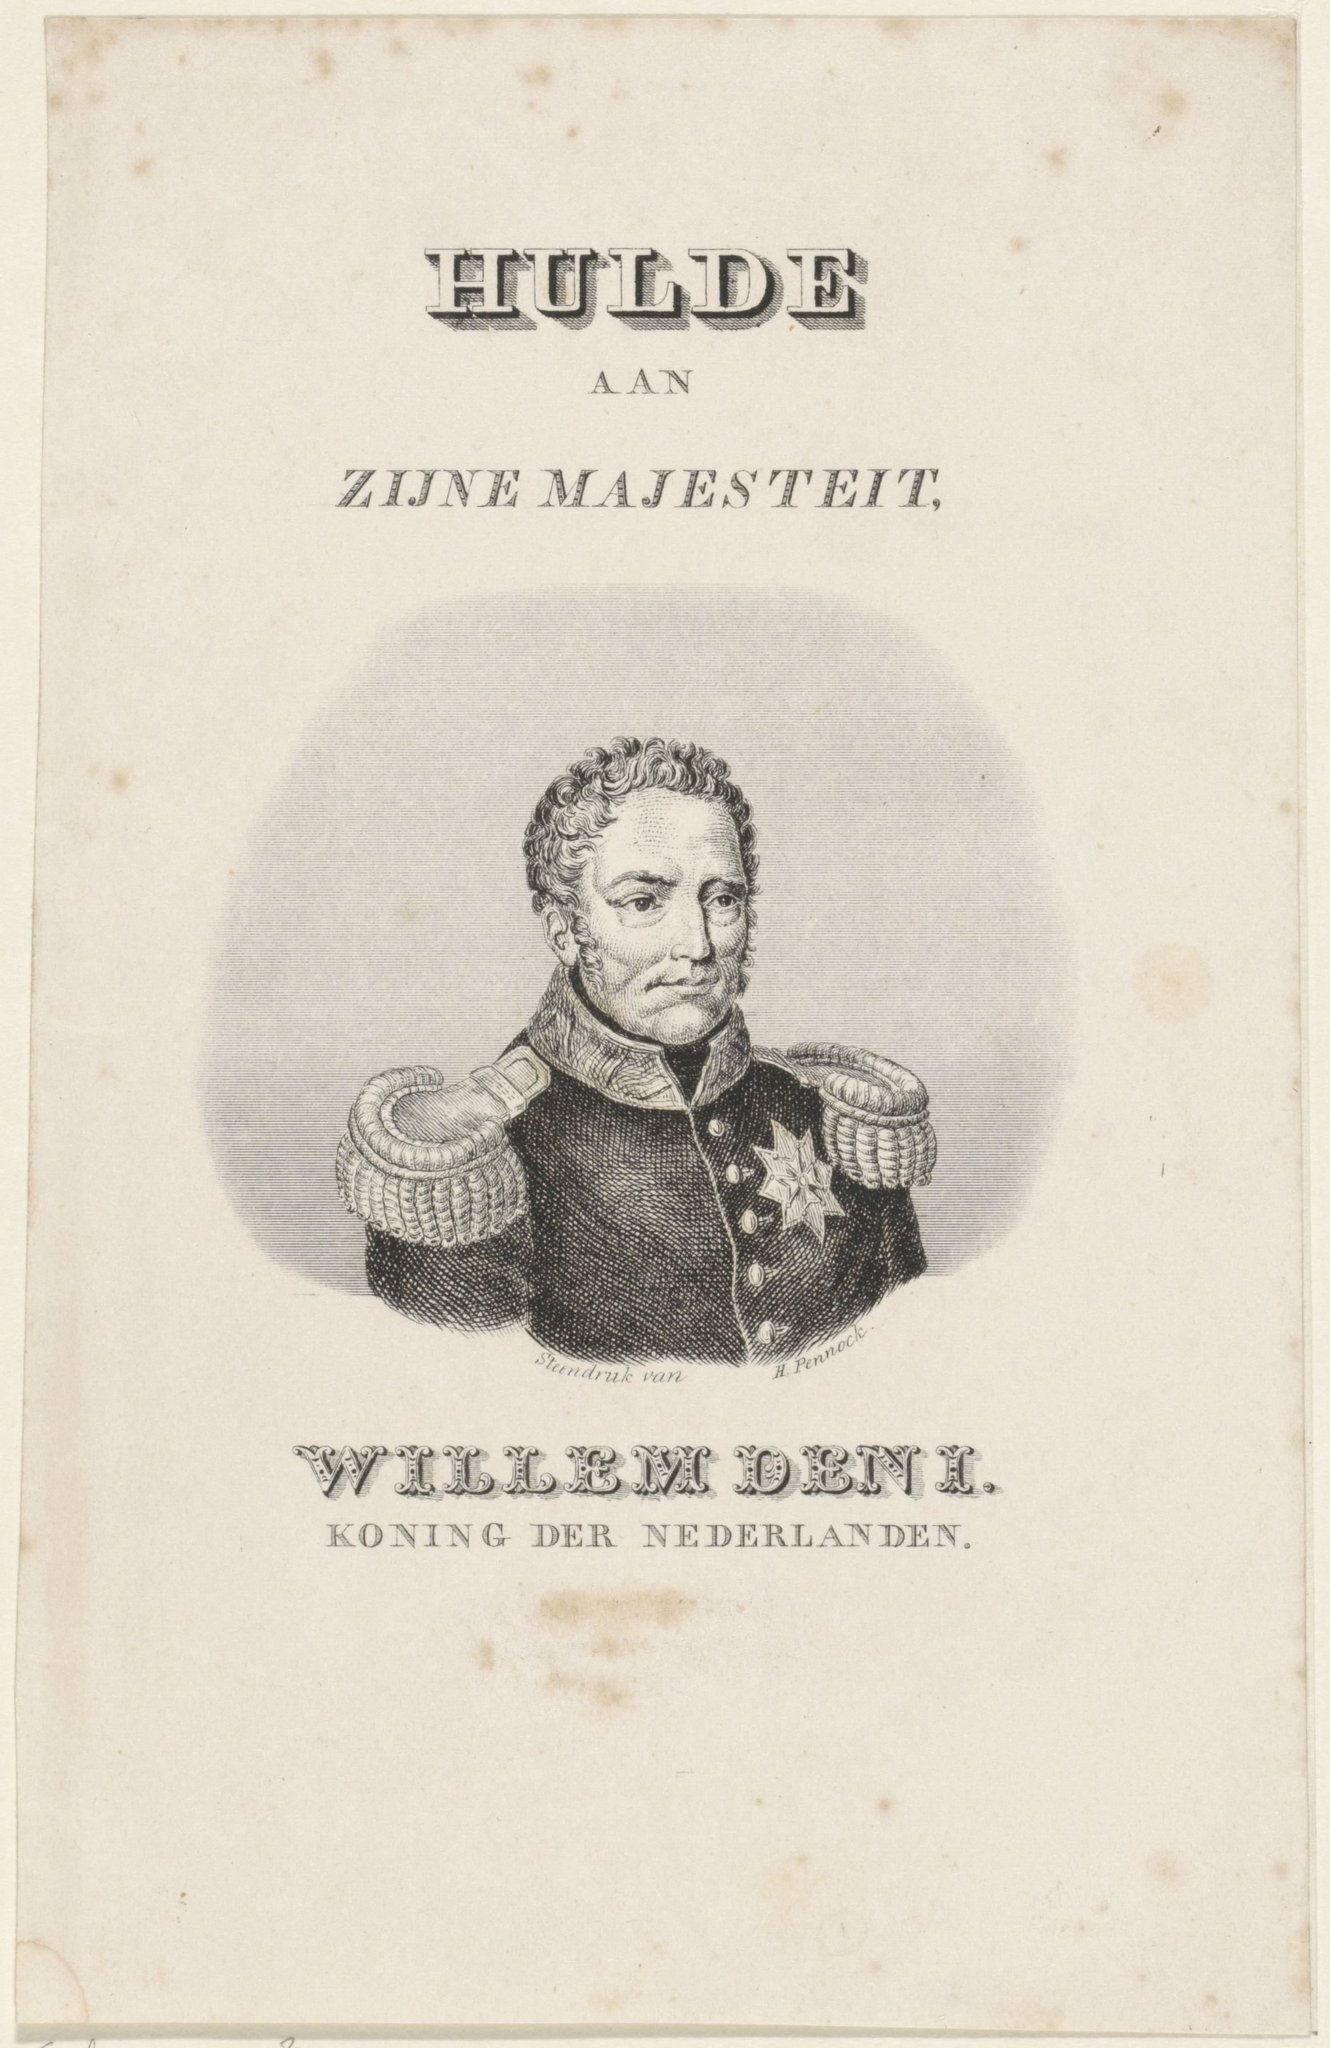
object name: print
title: Portret van Willem I Frederik, koning der Nederlanden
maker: hendrikus pennock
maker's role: print maker, printer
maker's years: 1814-1848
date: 1829-1848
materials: paper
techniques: lithograph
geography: dordrecht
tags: the hague, berlin, william i of the netherlands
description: De hier vermelde titel verwijst naar de hoogst verkregen titel van de geportretteerde, niet per se naar de titel die de geportretteerde op deze voorstelling draagt.